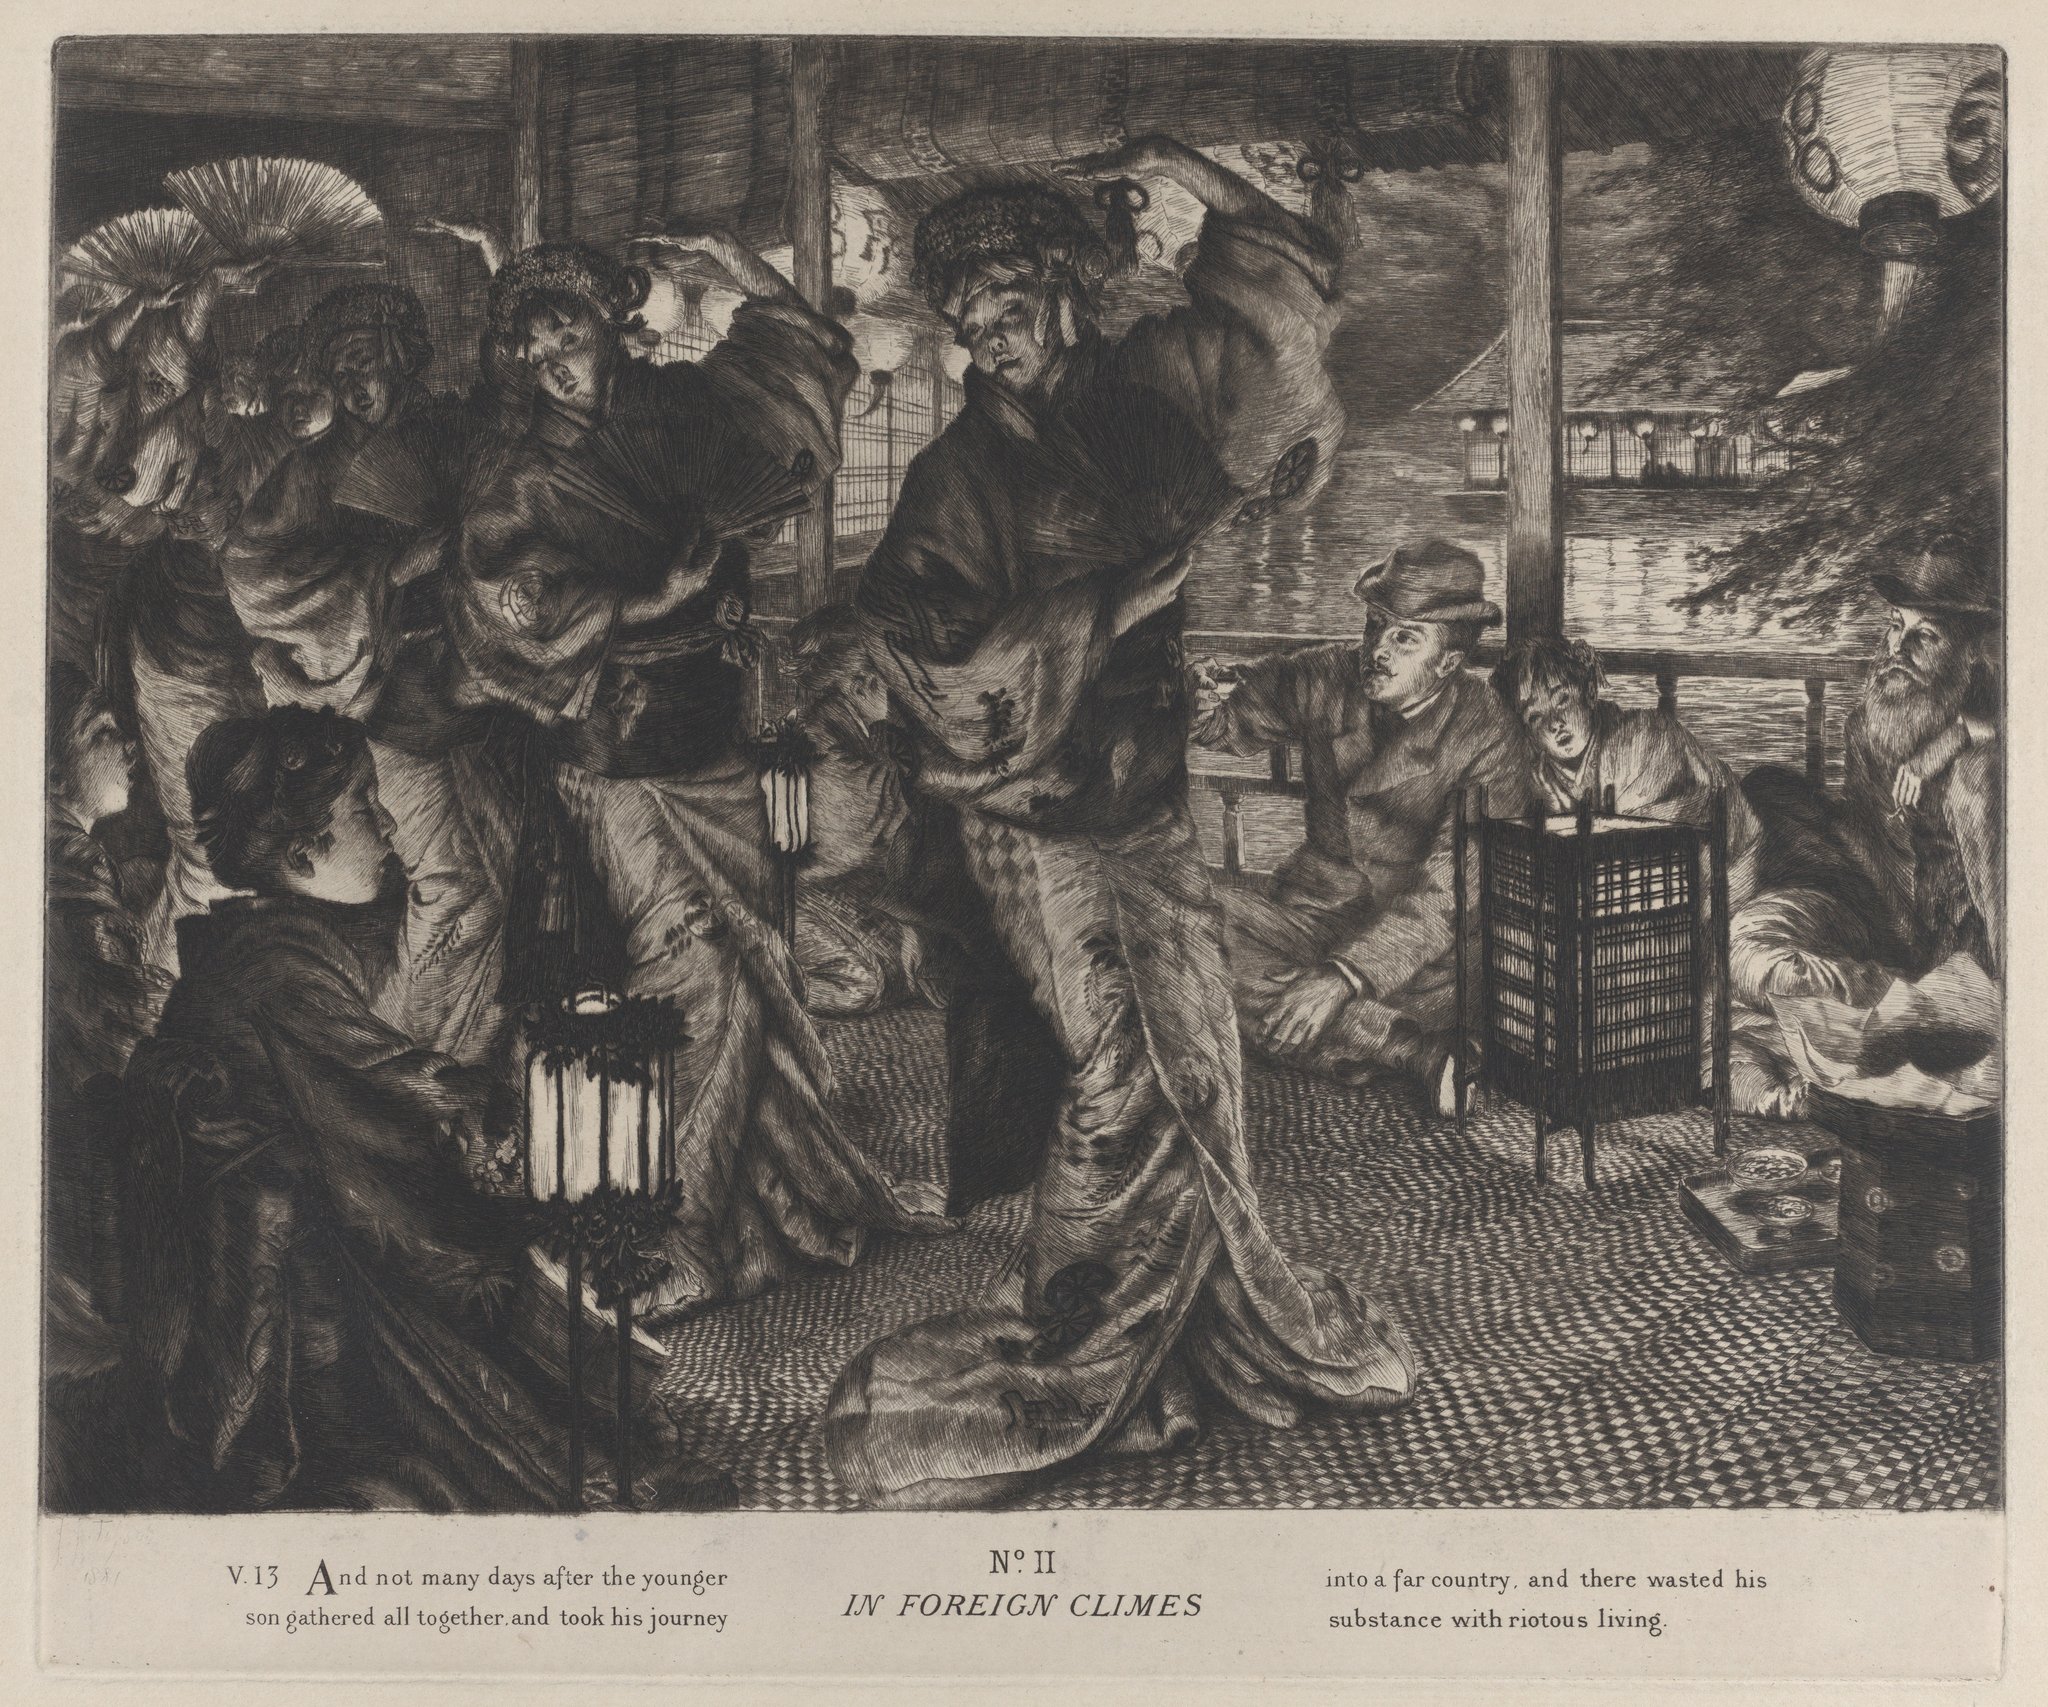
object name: print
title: The Parable of the Prodigal Son, No. II: In Foreign Climes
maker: james tissot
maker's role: artist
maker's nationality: french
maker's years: 1836-1902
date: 1882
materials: paper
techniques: etching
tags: men,women,dancing,dancers